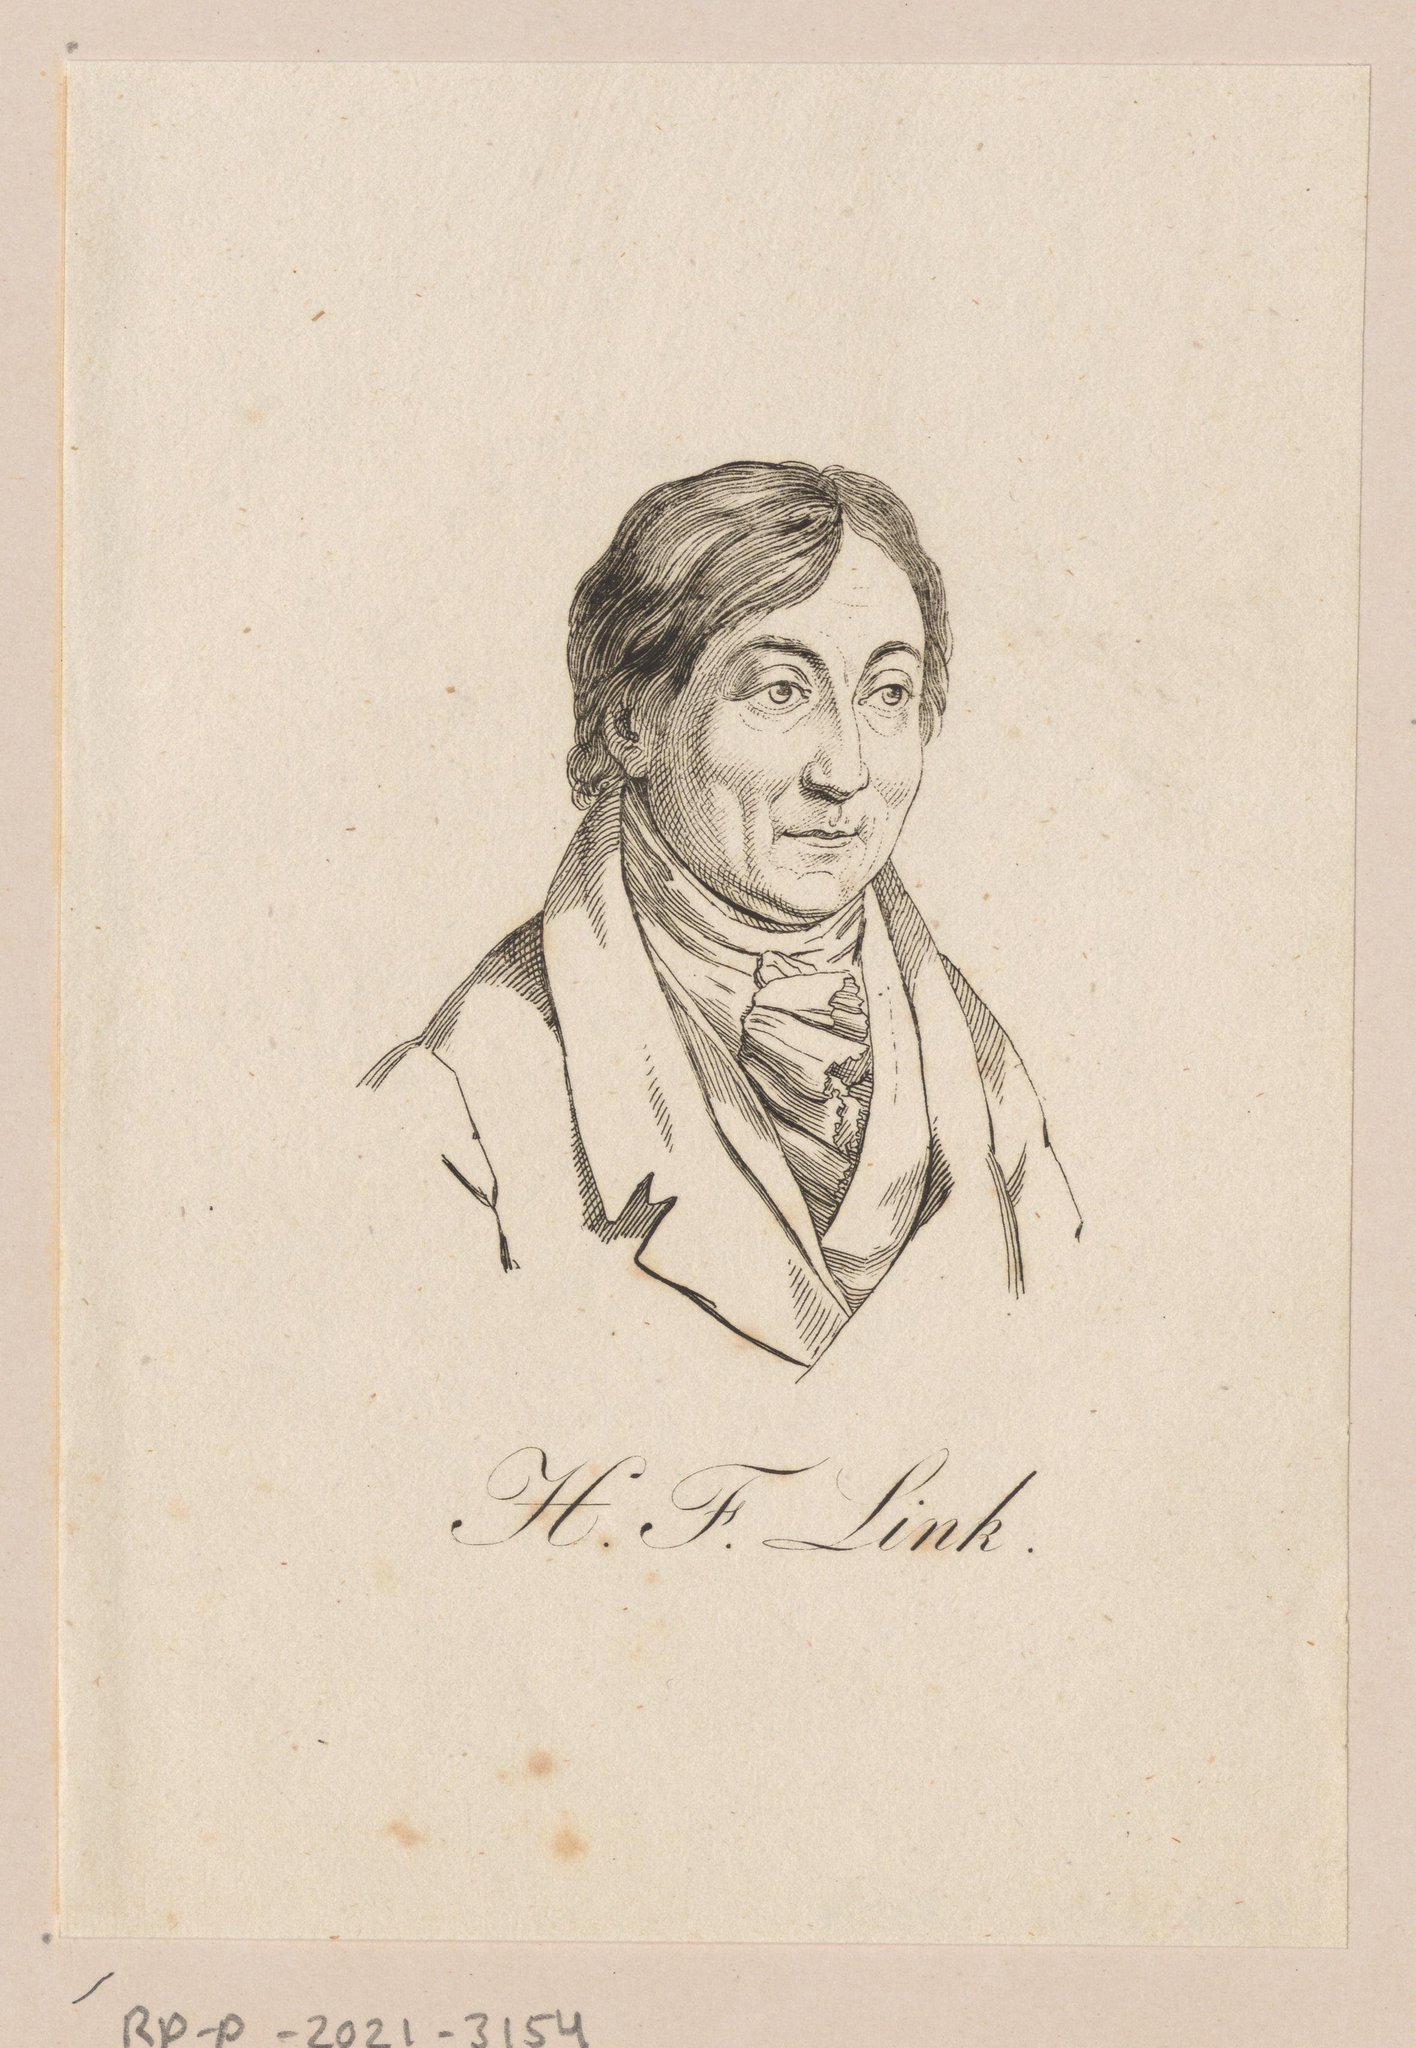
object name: print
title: Portret van Johann Heinrich Friedrich Link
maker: Anonymous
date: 1810-1899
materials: paper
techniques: etching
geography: germany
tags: botany (+ portrait of scholar, scientist), historical persons